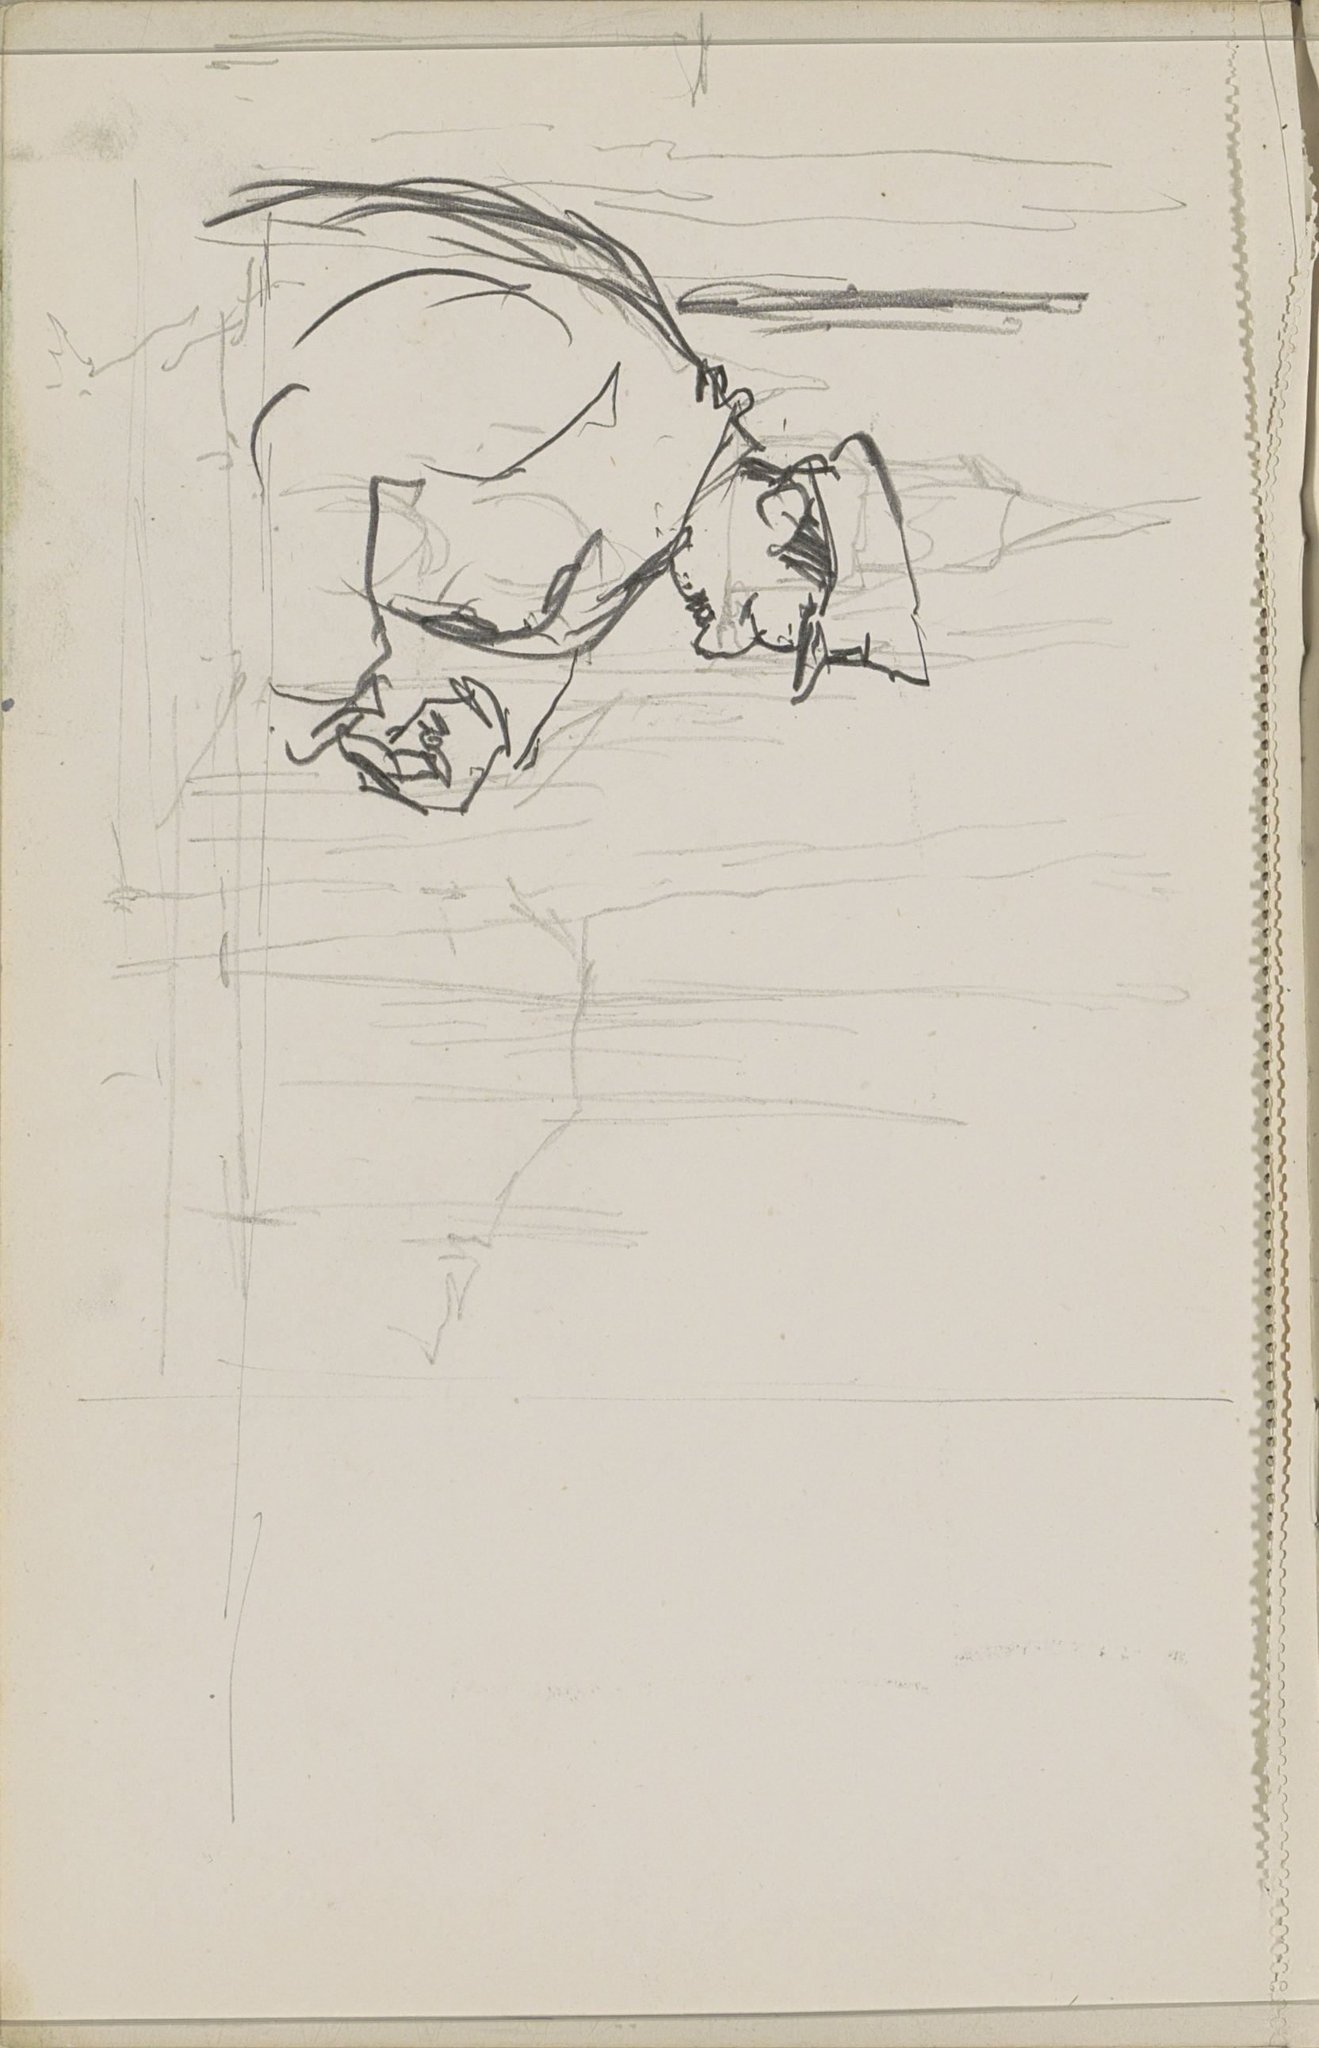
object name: sketchbook leaf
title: Zittende man met een pet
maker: cornelis vreedenburgh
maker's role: draughtsman, print maker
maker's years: 1880-1946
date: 1890-1946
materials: paper, pencil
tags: sitting figure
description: Blad 59 verso uit een schetsboek met 61 bladen.